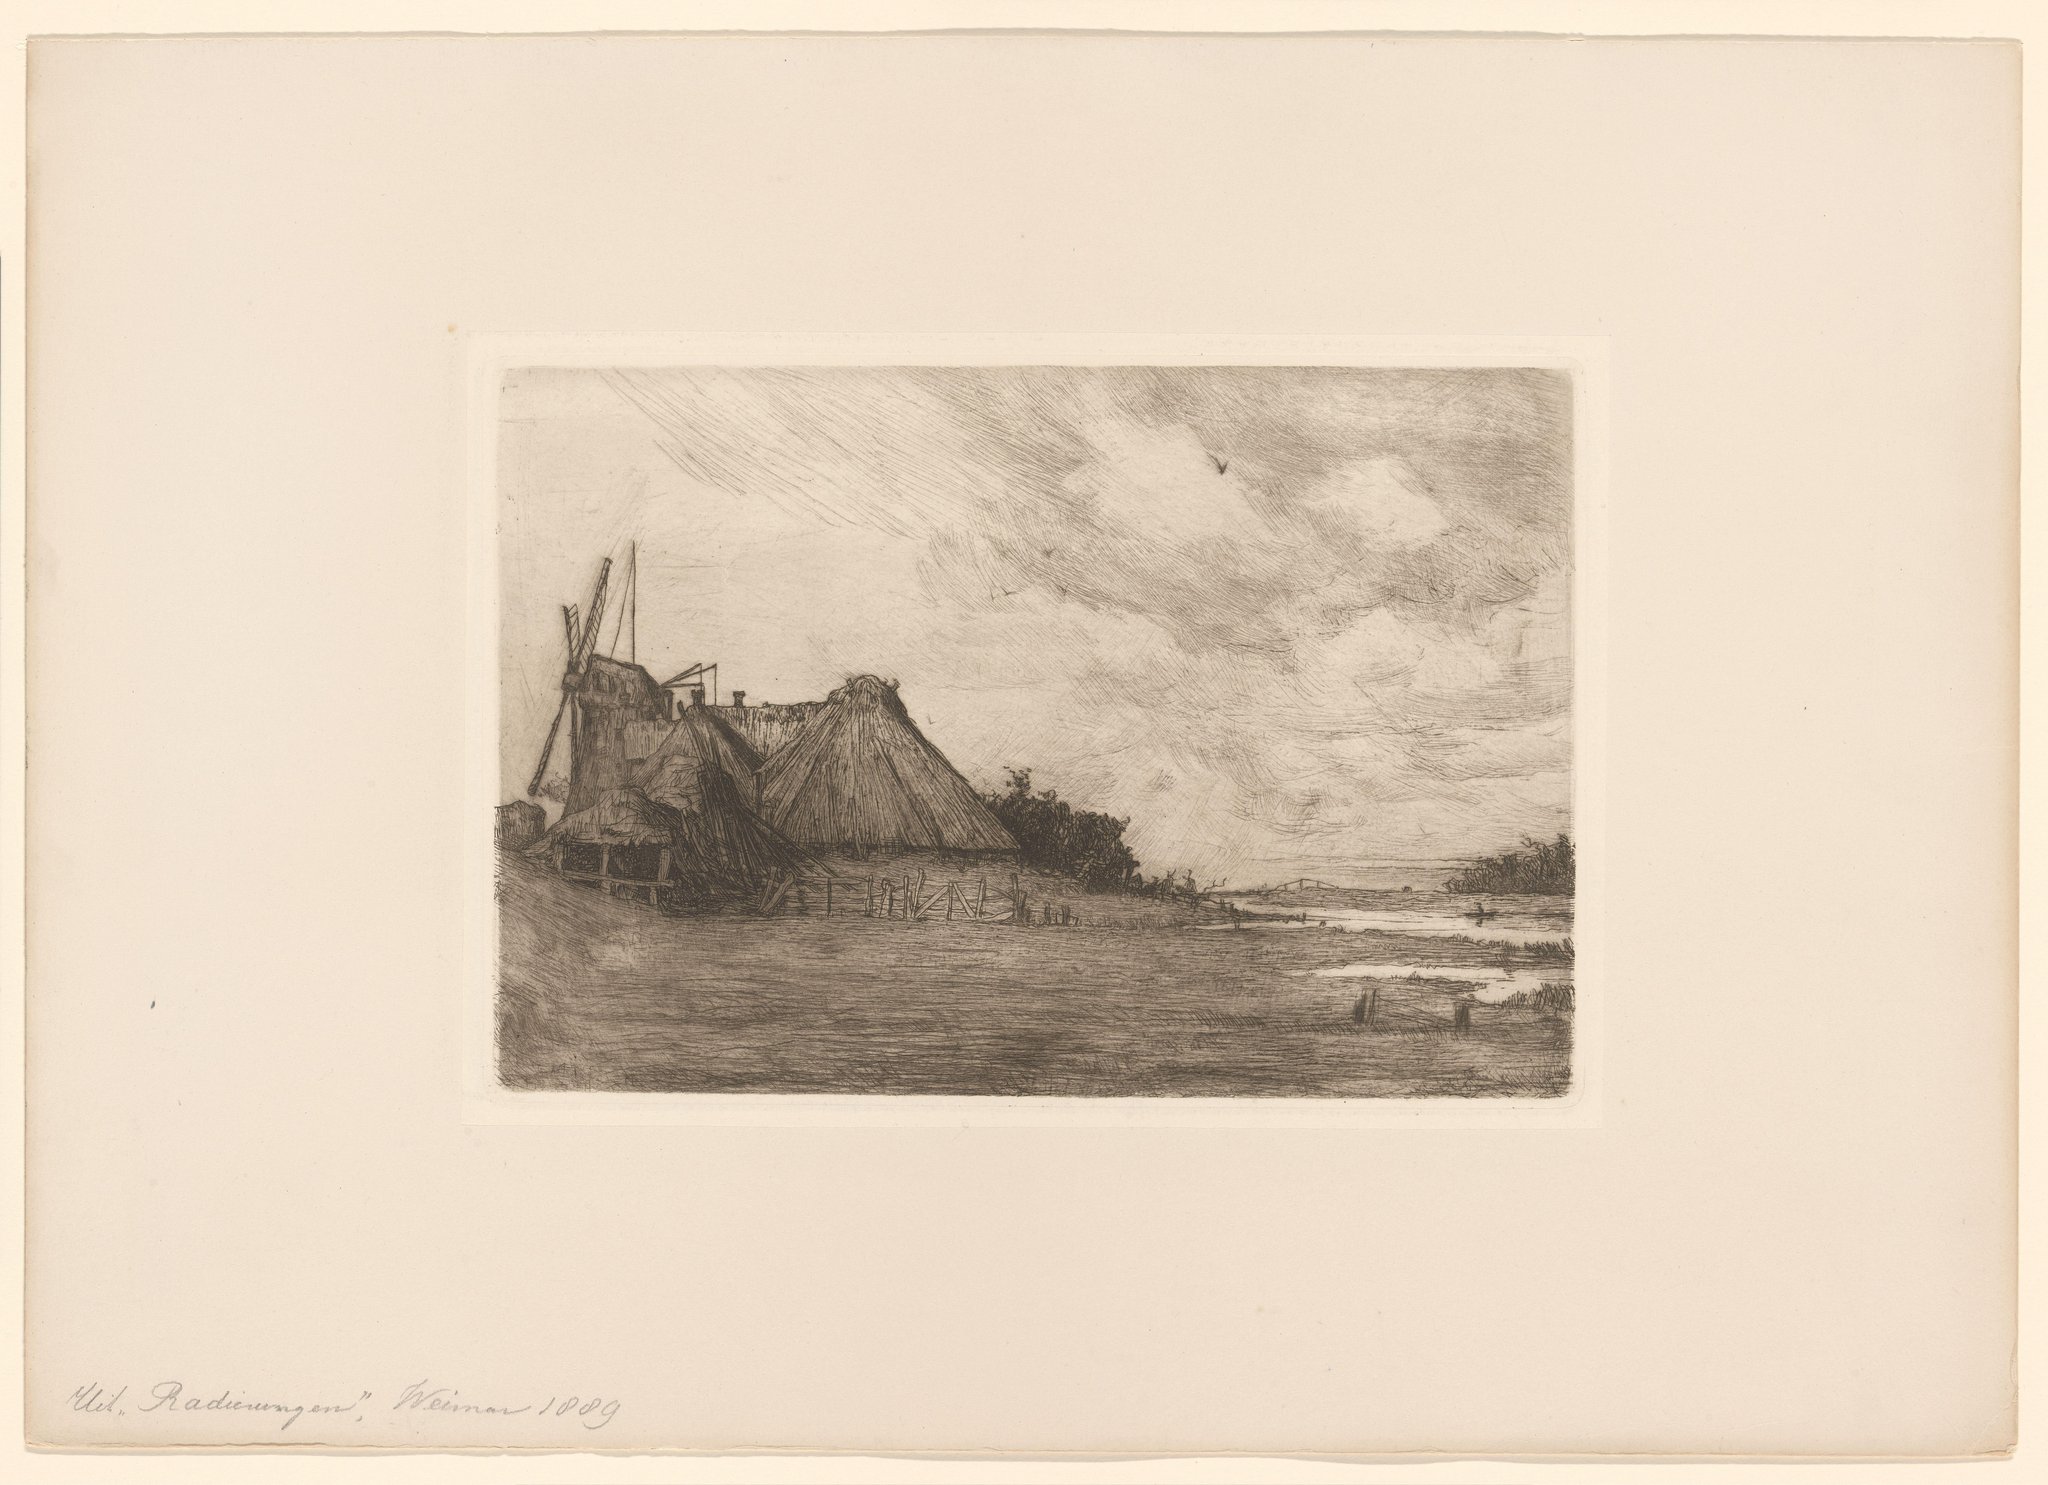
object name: print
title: Boerderij met molen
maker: benedikt momme nissen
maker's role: painter, print maker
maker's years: 1870-1943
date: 1889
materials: paper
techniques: drypoint, intaglio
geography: germany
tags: farm or solitary house in landscape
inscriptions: collector's mark: Lugt 2228, : ‘Uit "Radierungen", Weimar 1889.’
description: Prent maakt deel uit van een groep prenten die tussen 1880 en 1895 werd uitgegeven door het Gesellschaft für Radierkunst te Weimar.